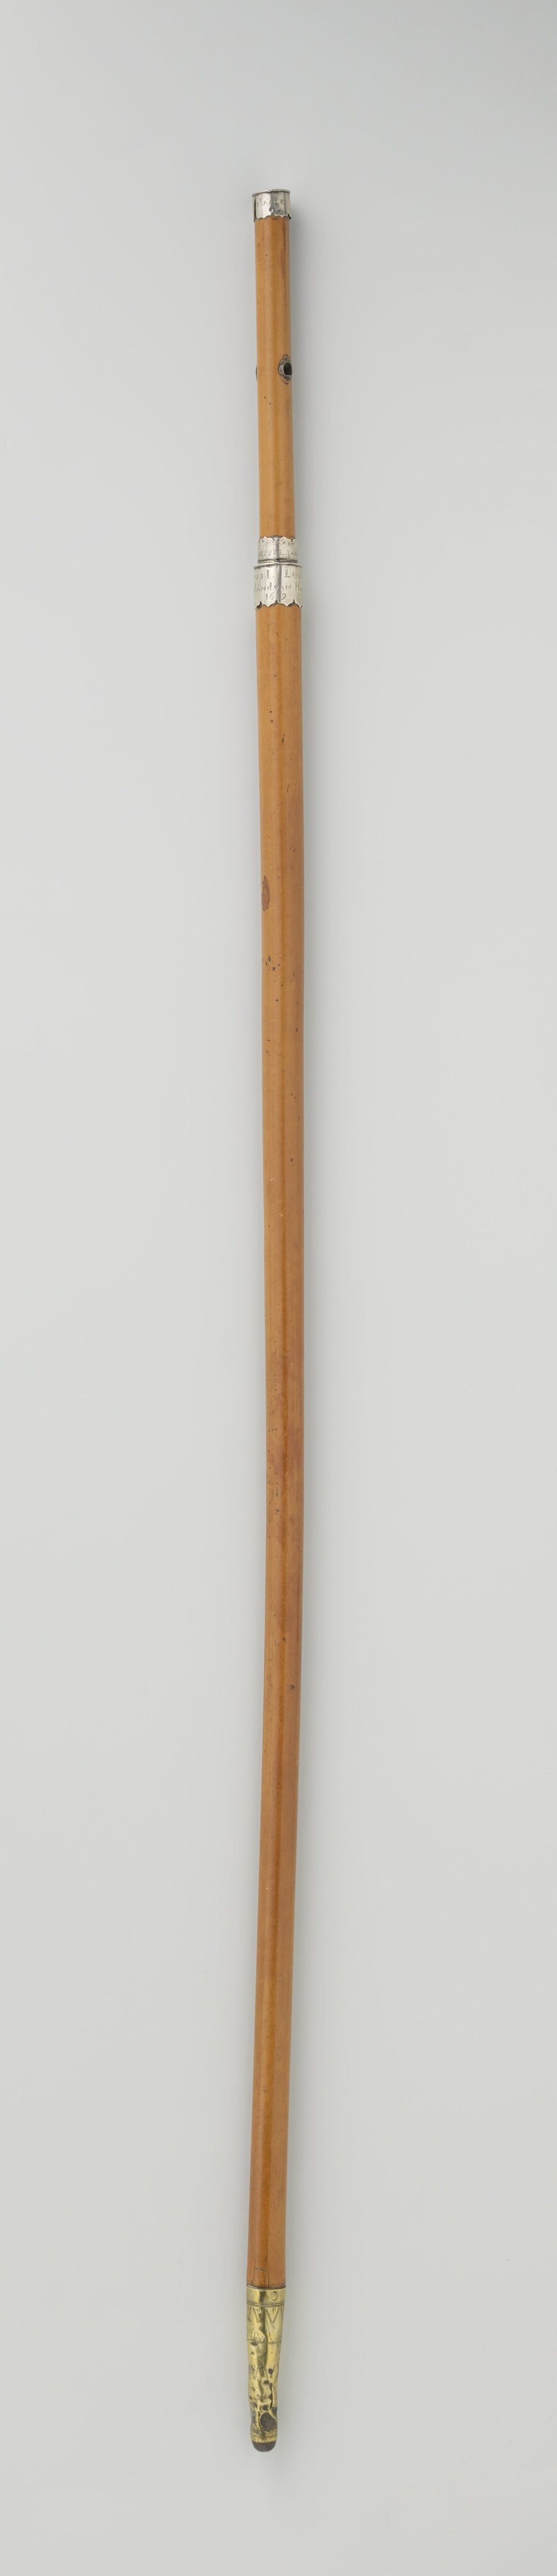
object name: walking stick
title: Walking Stick Belonging to Lieutenant Admiral Jan Corneliszoon Meppel (1609-1669)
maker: Anonymous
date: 1659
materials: brass, rattan, silver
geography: netherlands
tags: hoorn (north holland), jan corneliszoon meppel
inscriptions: mark, inscription: ‘Geschenk van de staate’, inscription: ‘Aan / Jan Corneliszoon Meppel / Luitenant Admiraal / van Holland en Westvrisland / 1659’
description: Rotting of wandelstok van rotan met versierde knop, oog, hals en punt. Op de hals een zilveren band met inscriptie "Aan / Jan Corneliszoon Meppel / Luitenant Admiraal / van Holland en Westvrisland / 1659". Op de knop een gegraveerd portret met de afbeelding van luitenant-admiraal Jan Corneliszoon Meppel (1609-1669) en langs de zijde de tekst "Geschenk van de staate". De messing punt is versierd met geometrische motieven.